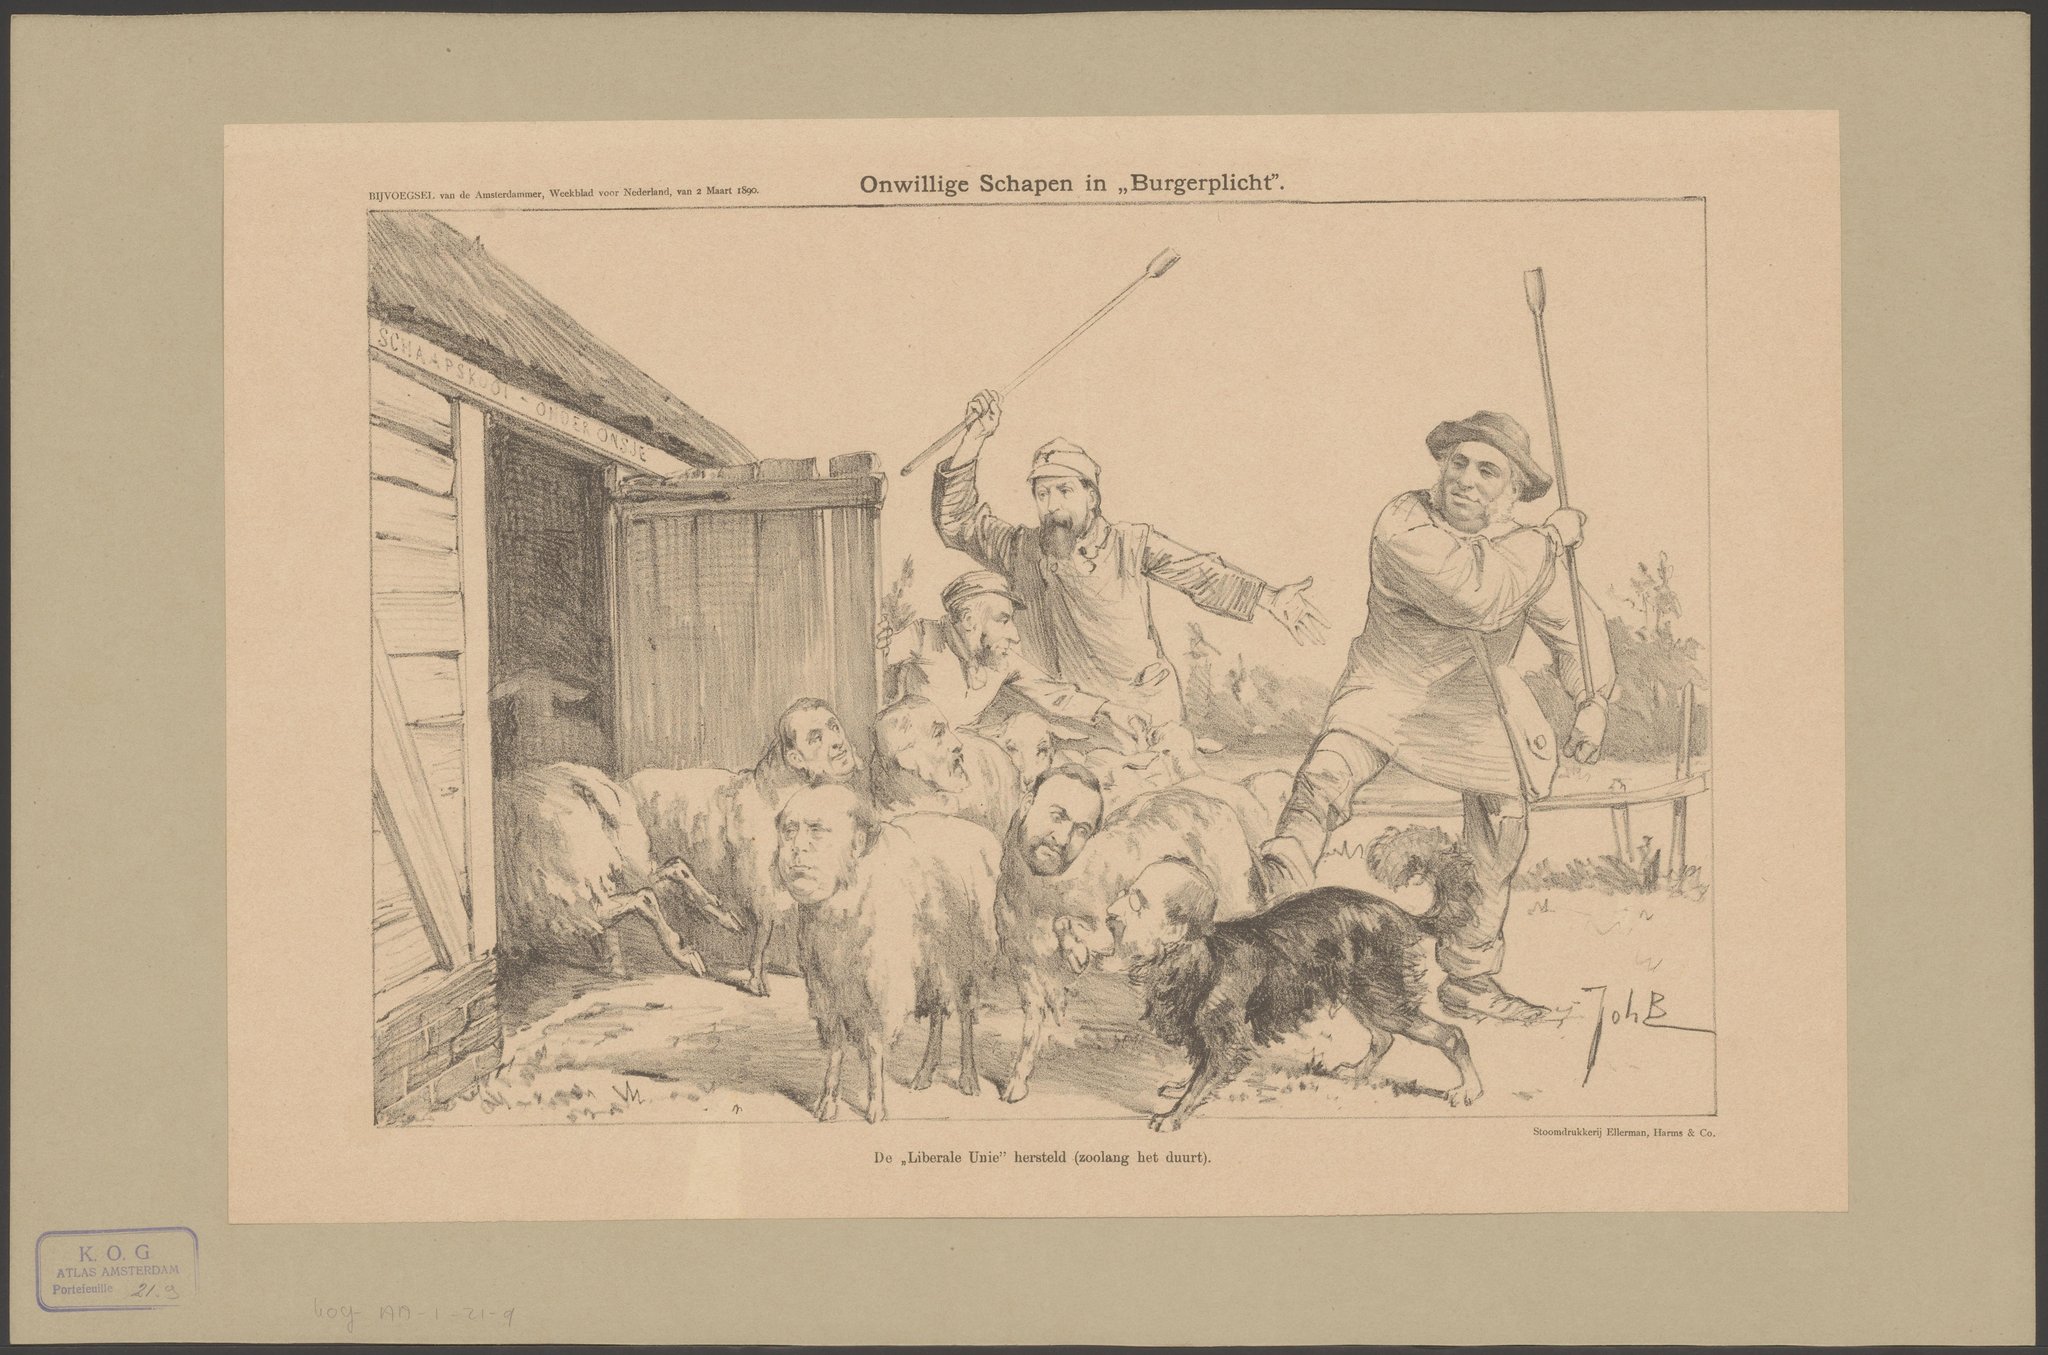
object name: cartoon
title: Onwillige schapen in "Burgerplicht"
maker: johan braakensiek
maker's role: draughtsman, print maker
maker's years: 1858-1940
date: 1890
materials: paper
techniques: letterpress printing, lithograph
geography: amsterdam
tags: amsterdam, politician, return to the fold, byre, stable ~ herd, herdsman, herding, herdsman, herdswoman, shepherd, shepherdess, cowherd, etc., politician, e.g. party leader, sheep, herd, flock, political caricatures and satires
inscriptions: collector's mark: Lugt 1641b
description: Abraham Carel Wertheim als één van de drie herders die samen met een herdershond proberen de kudde schapen in de schaapskooi te krijgen. De hond en de schapen hebben de hoofden van liberale politici, leden van de kiesvereniging 'Burgerplicht'. Onderwerpsrubriek binnen de Atlas Amsterdam: Kiesverenigingen, Politieke partijen.